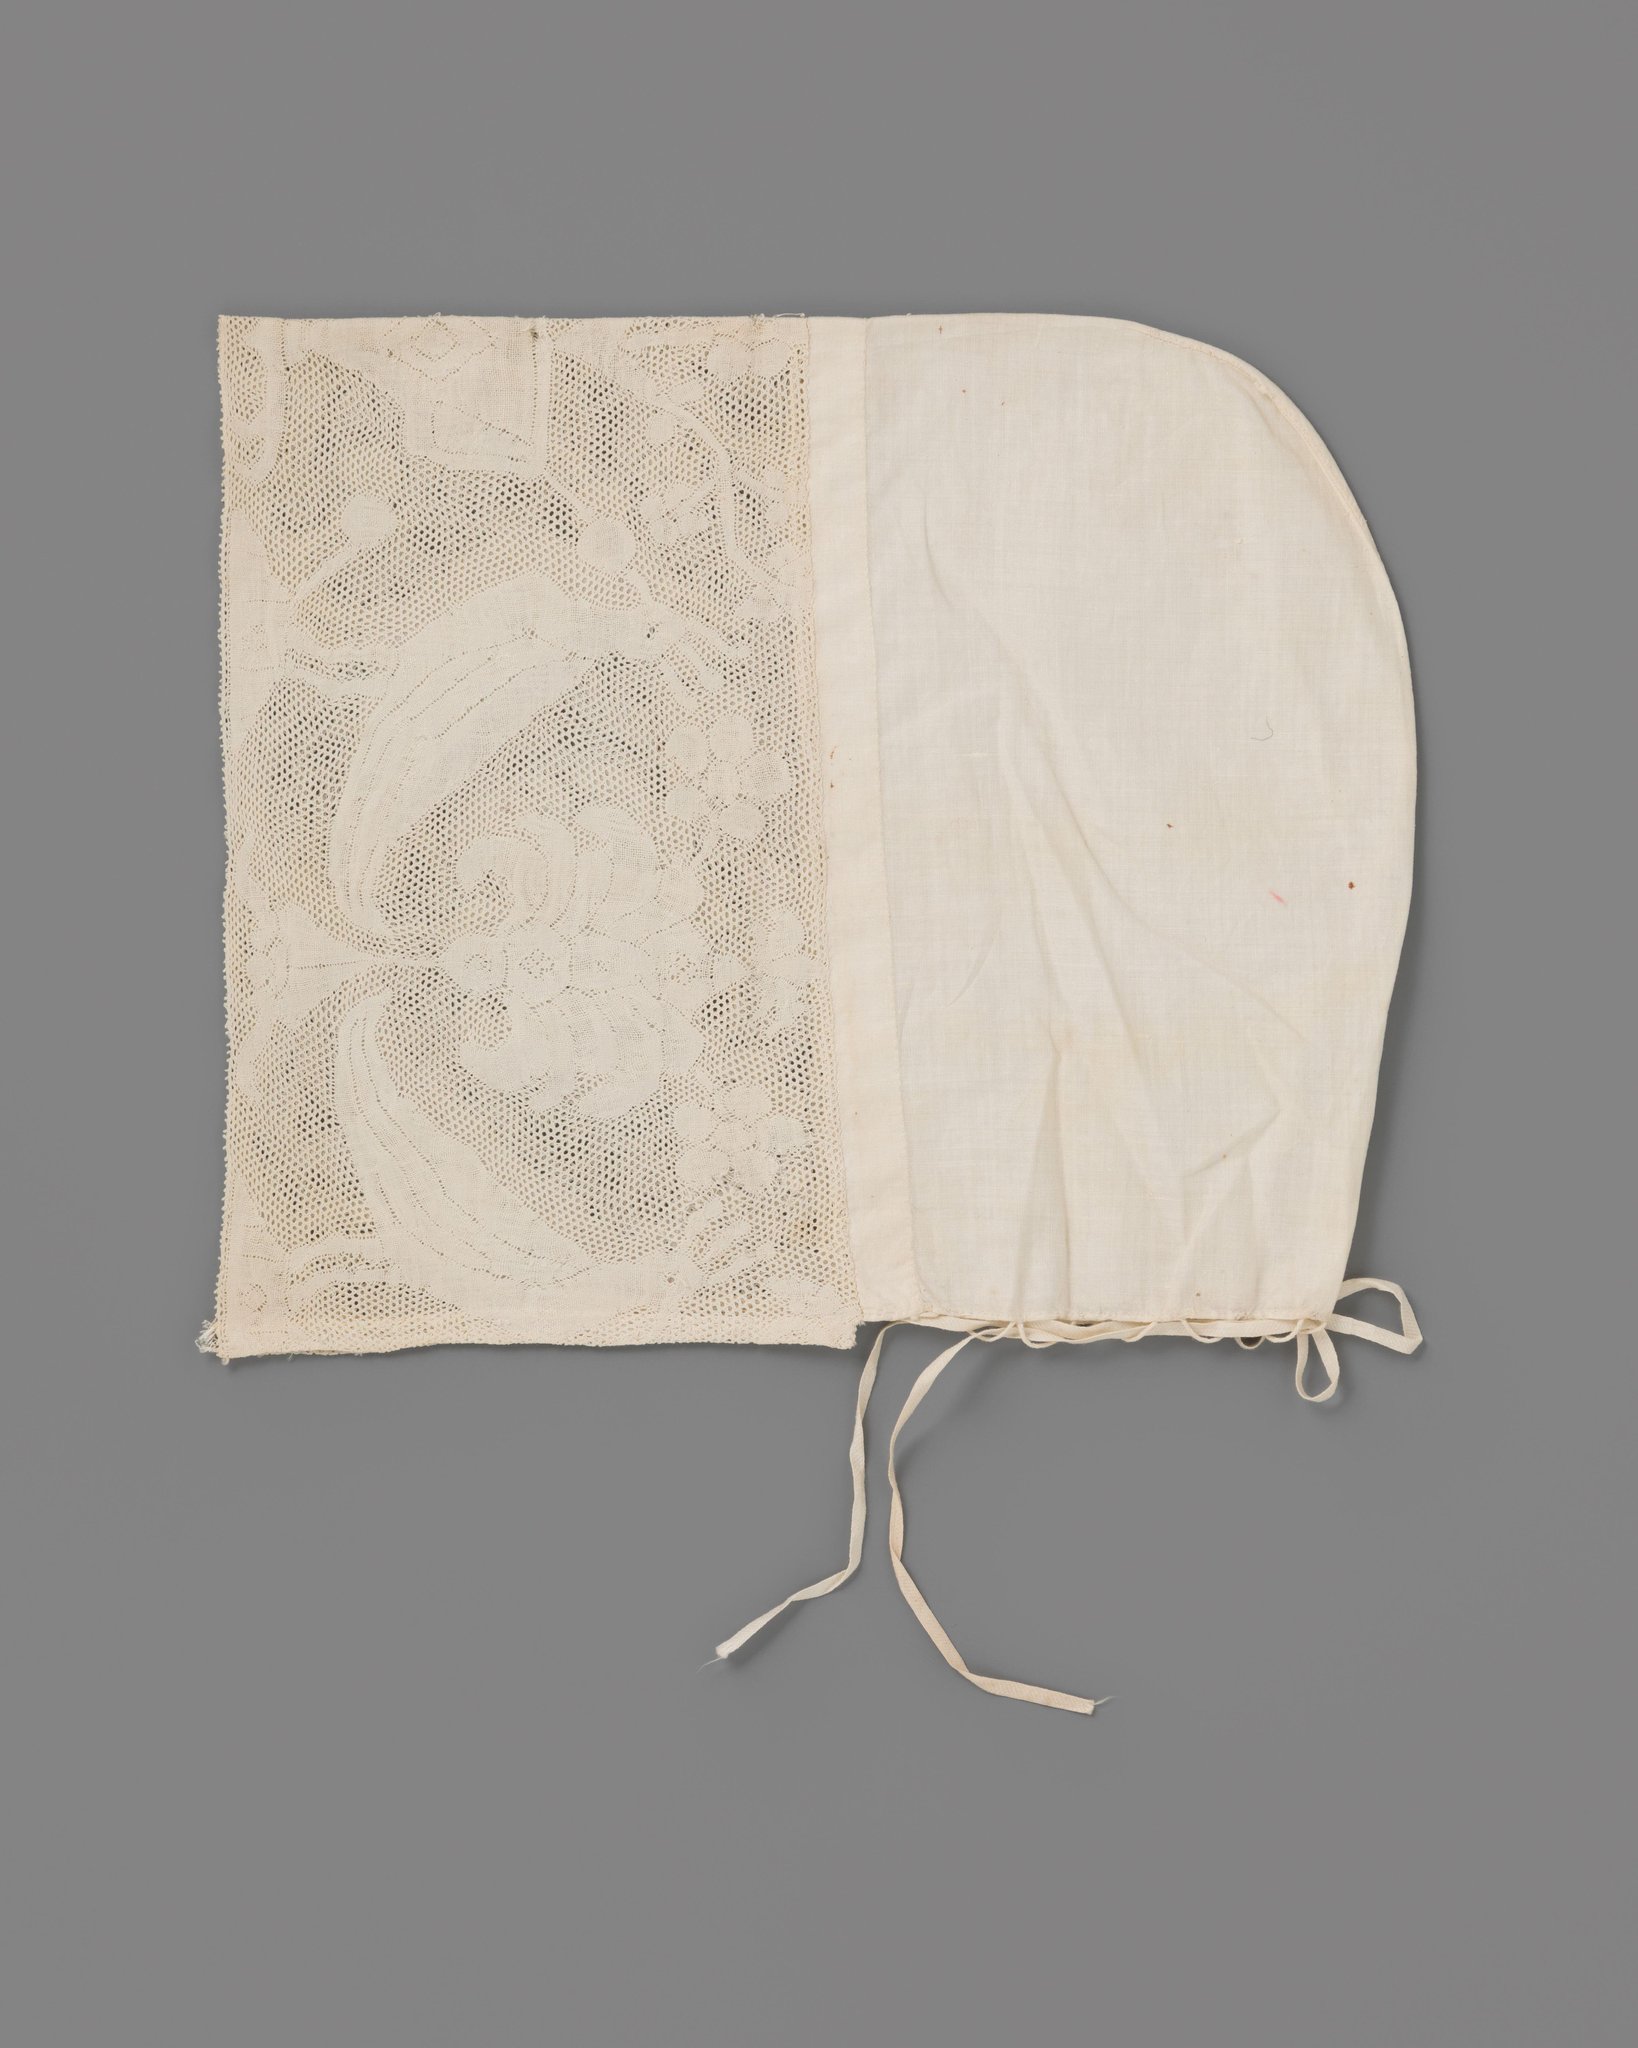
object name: strip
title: Linnen muts met strook Antwerpse pottenkant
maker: Anonymous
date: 1800-1900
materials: linen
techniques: lace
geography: flanders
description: Linnen muts met een kanten strook. De kanten strook is van Antwerpse pottenkant en heeft een patroon van een vaas met bloemen waarin twee vogels pikken. Dit motief herhaalt zich en tussen de motieven is een groot palmet. De muts kan worden dichtgeregen door middel van een rijgkoord.